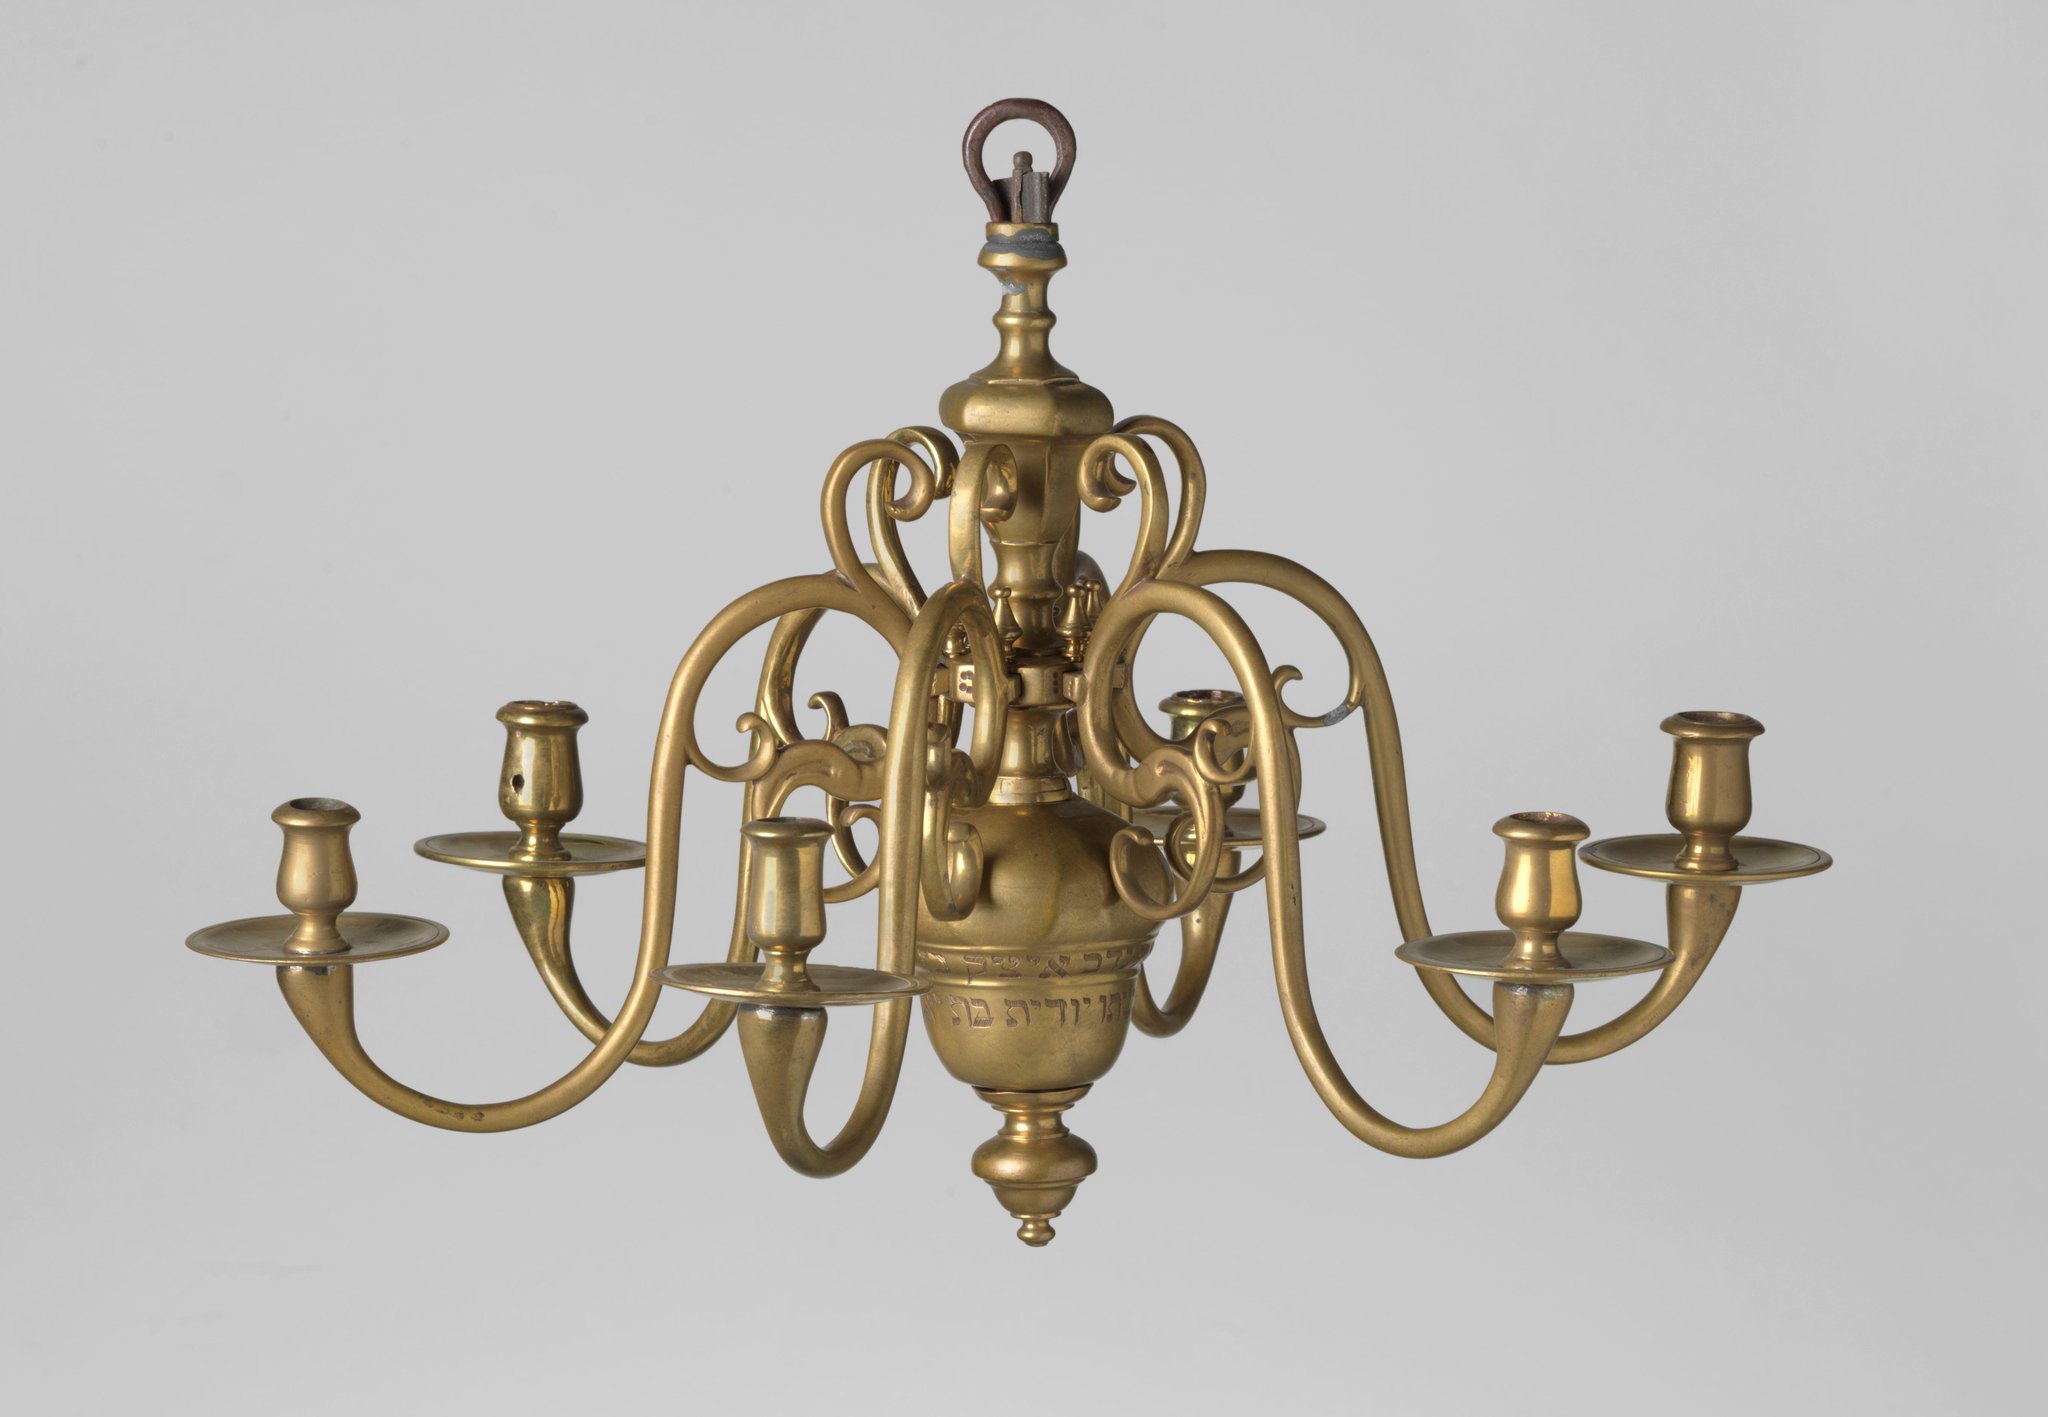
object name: chandelier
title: Arm met kaarsenhouder van kaarsenkroon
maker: Anonymous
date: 1795-1800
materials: brass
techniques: casting, screwed, turning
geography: amsterdam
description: De S-vormige arm heeft een krul op het eind aan de stamzijde en gaat naar buiten toe over in een verdikking met schroefgat. Daarin is de kaarsenhouder met de vetvanger vastgezet. De ronde houder heeft een holrond voetstuk, versmalt zich naar boven toe en heeft vervolgens een uitstekende rand. De vetvanger heeft aan de bovenkant een gegroefde ring. Dit is de tweede arm, ongenummerd.